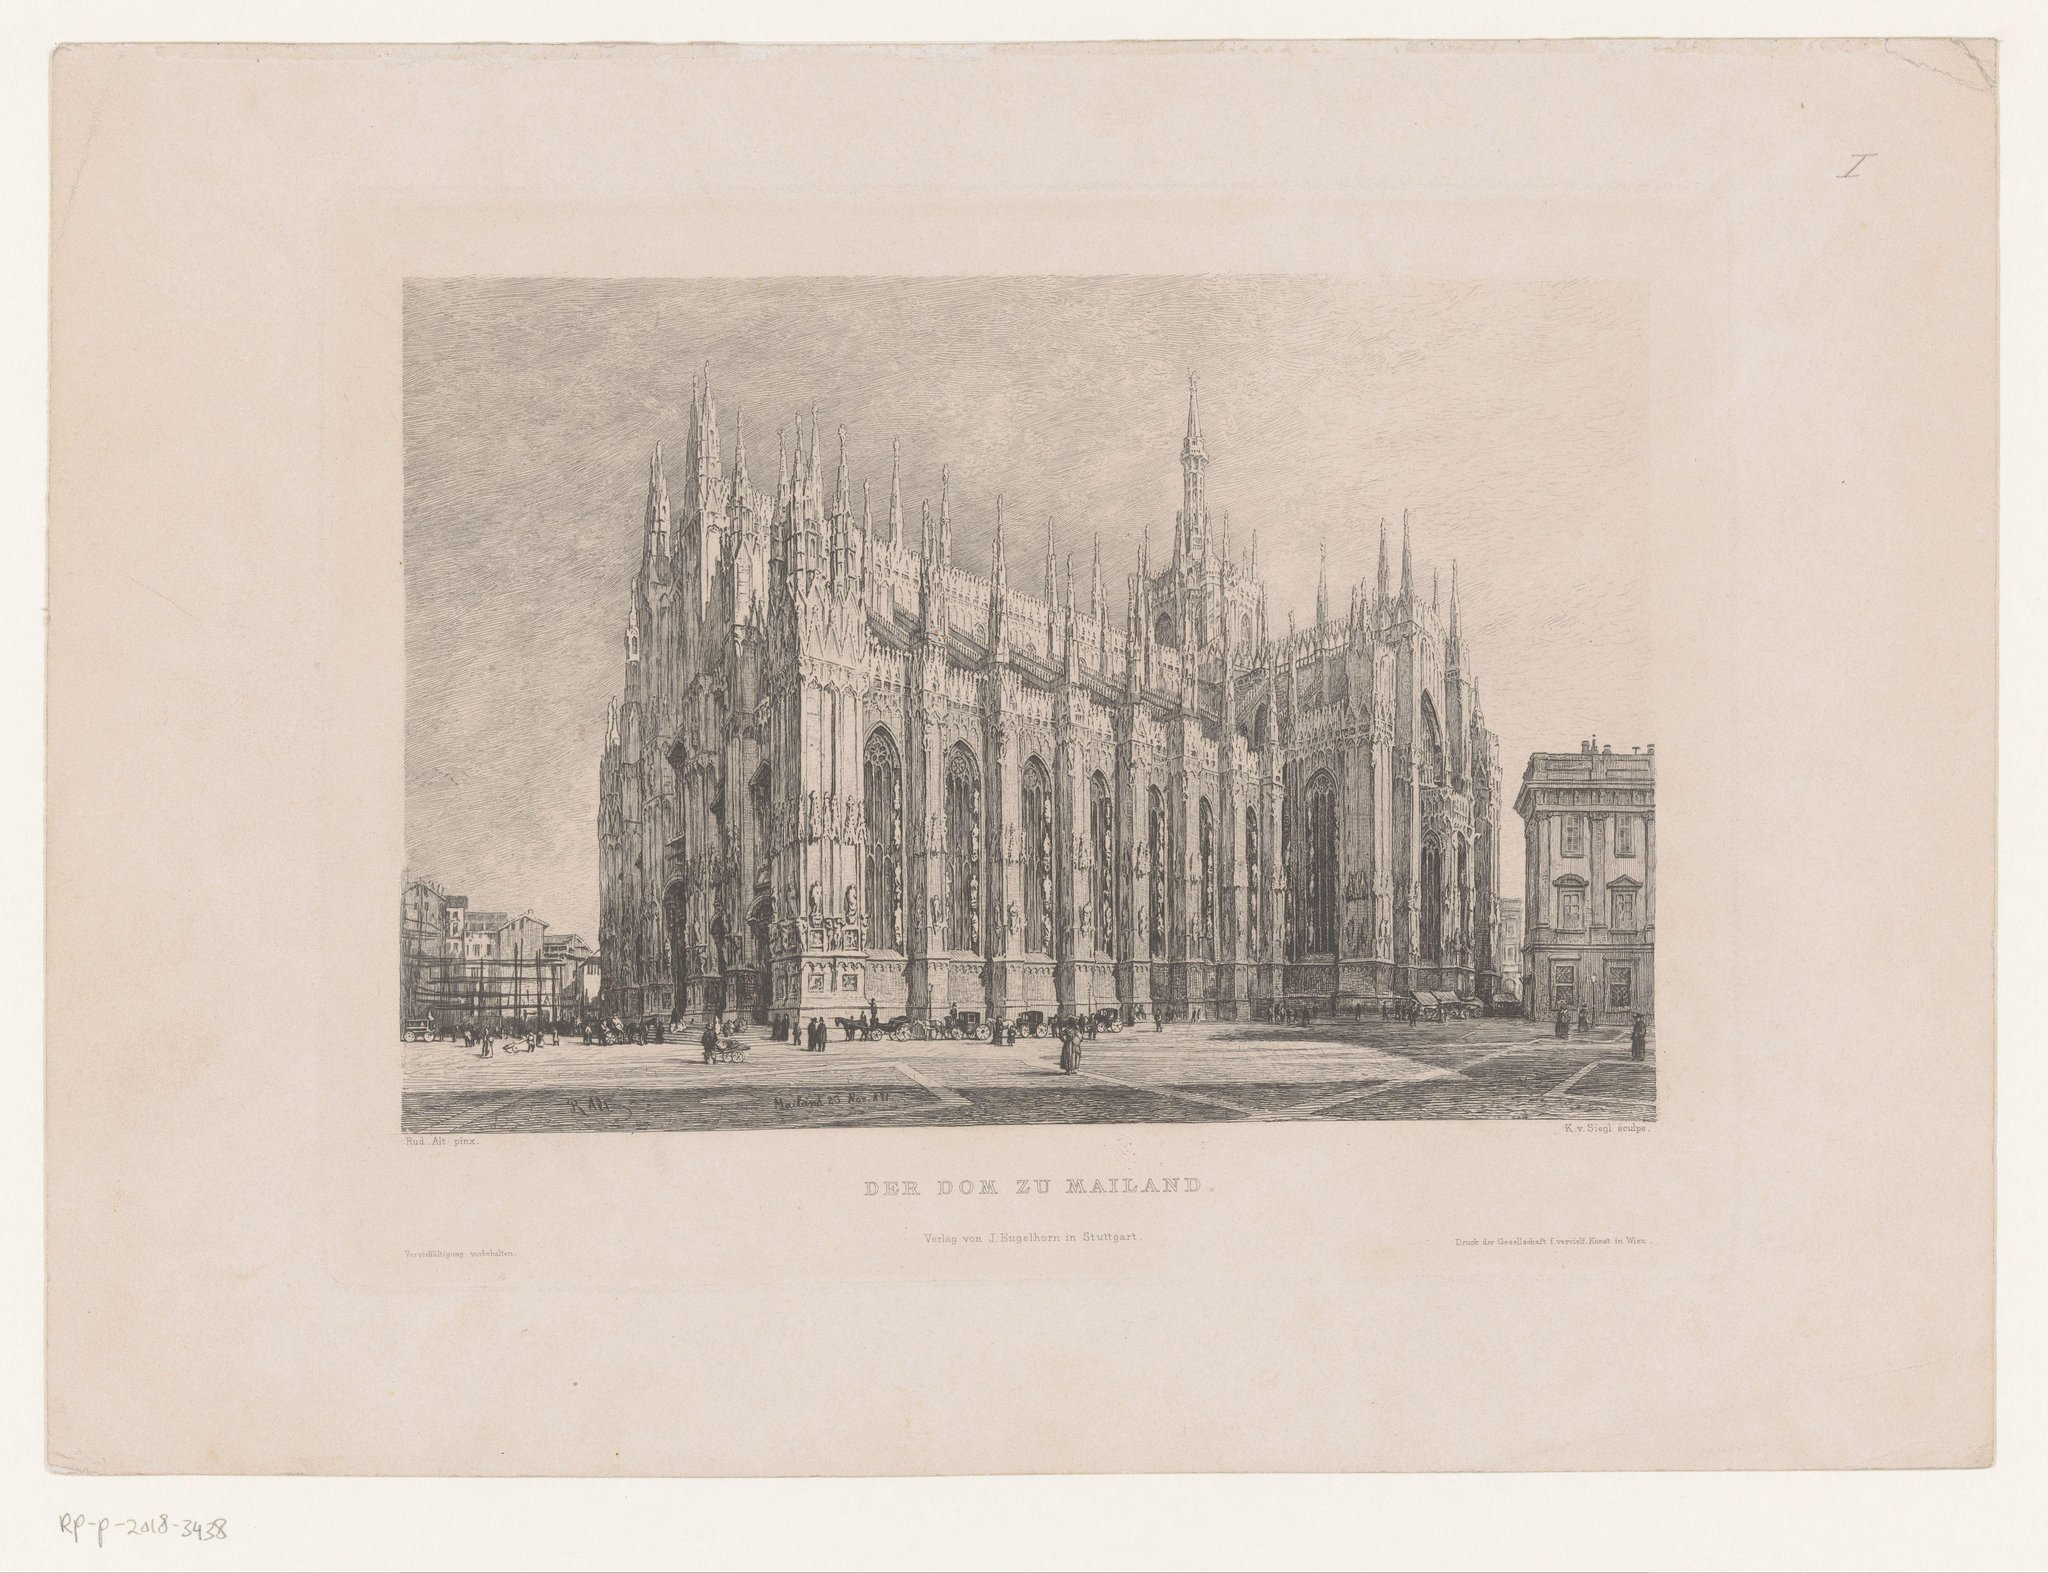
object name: print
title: Der Dom zu Mailand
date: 1871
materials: paper, pencil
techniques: etching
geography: vienna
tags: roman catholic church, representation of real building (either existing or having existed), exterior ~ representation of a building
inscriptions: collector's mark: Lugt 3937